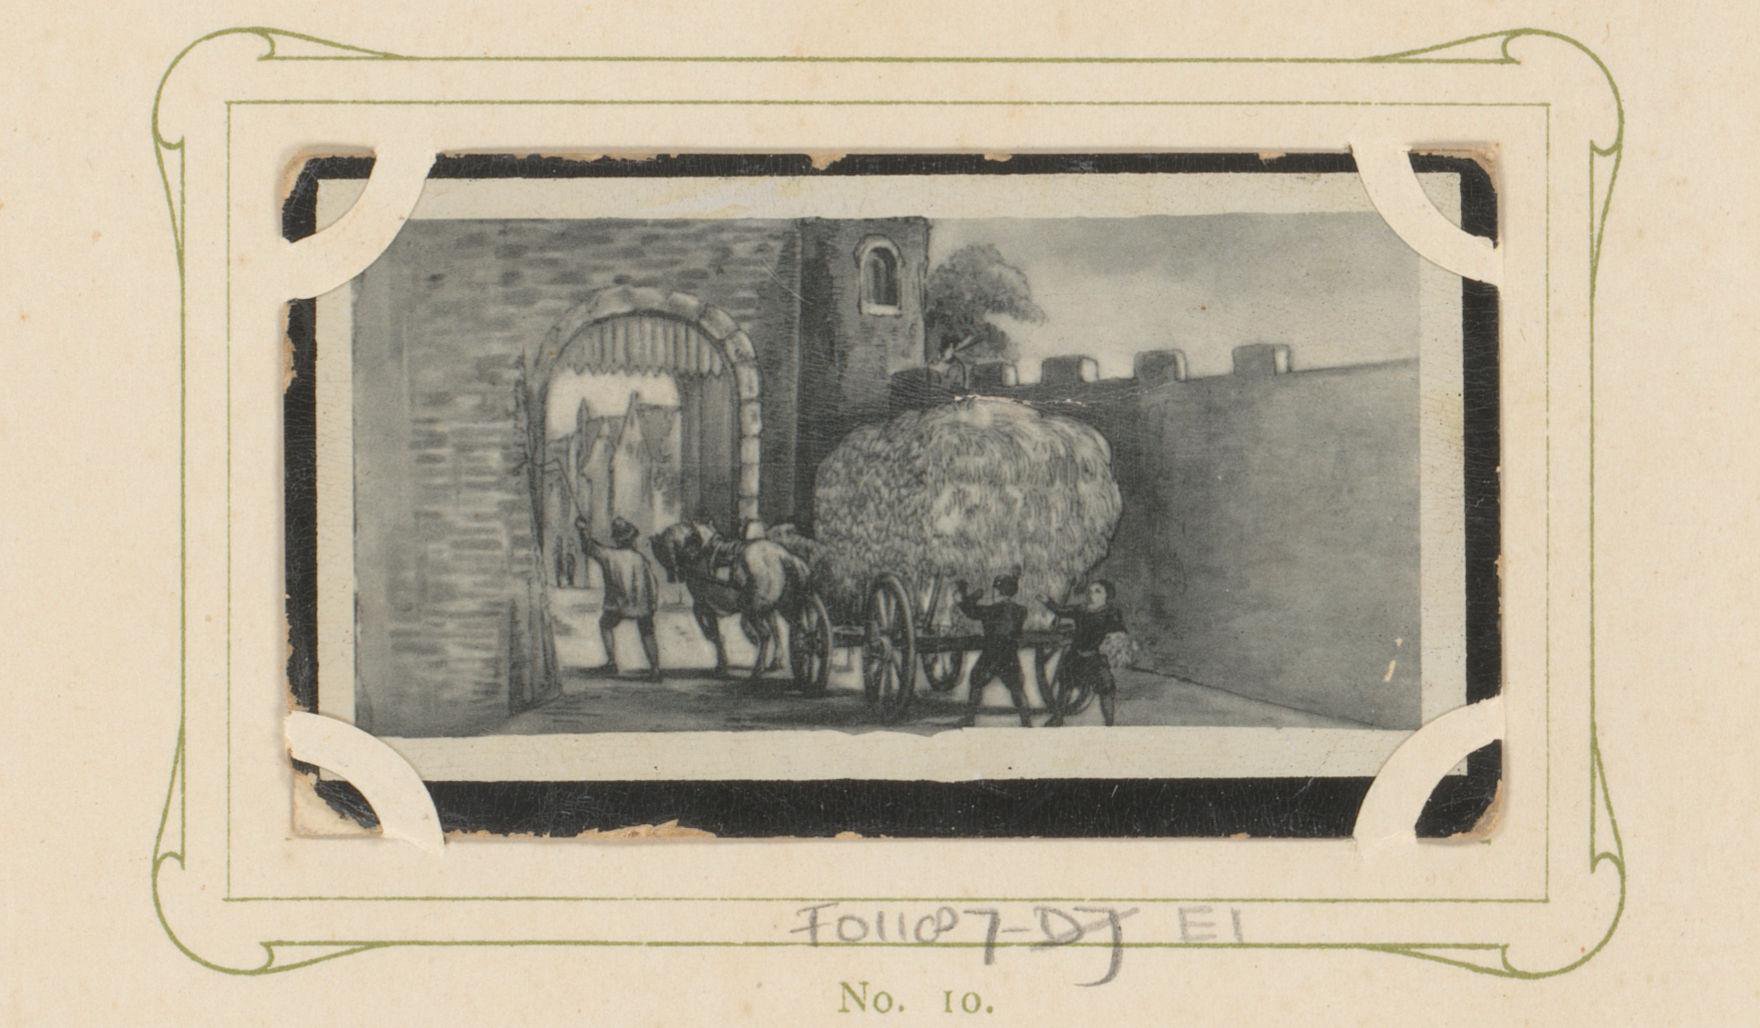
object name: reproduction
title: Reproductie van een tekening van de mislukte Aanval op Lochem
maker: Anonymous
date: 1905-1906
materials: paper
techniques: photograph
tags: (military) attack, hay-wagon, city-gate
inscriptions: inscription: ‘No. 10./ Mislukte aanval op Lochem.’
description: Deze prent maakt deel uit van een album.